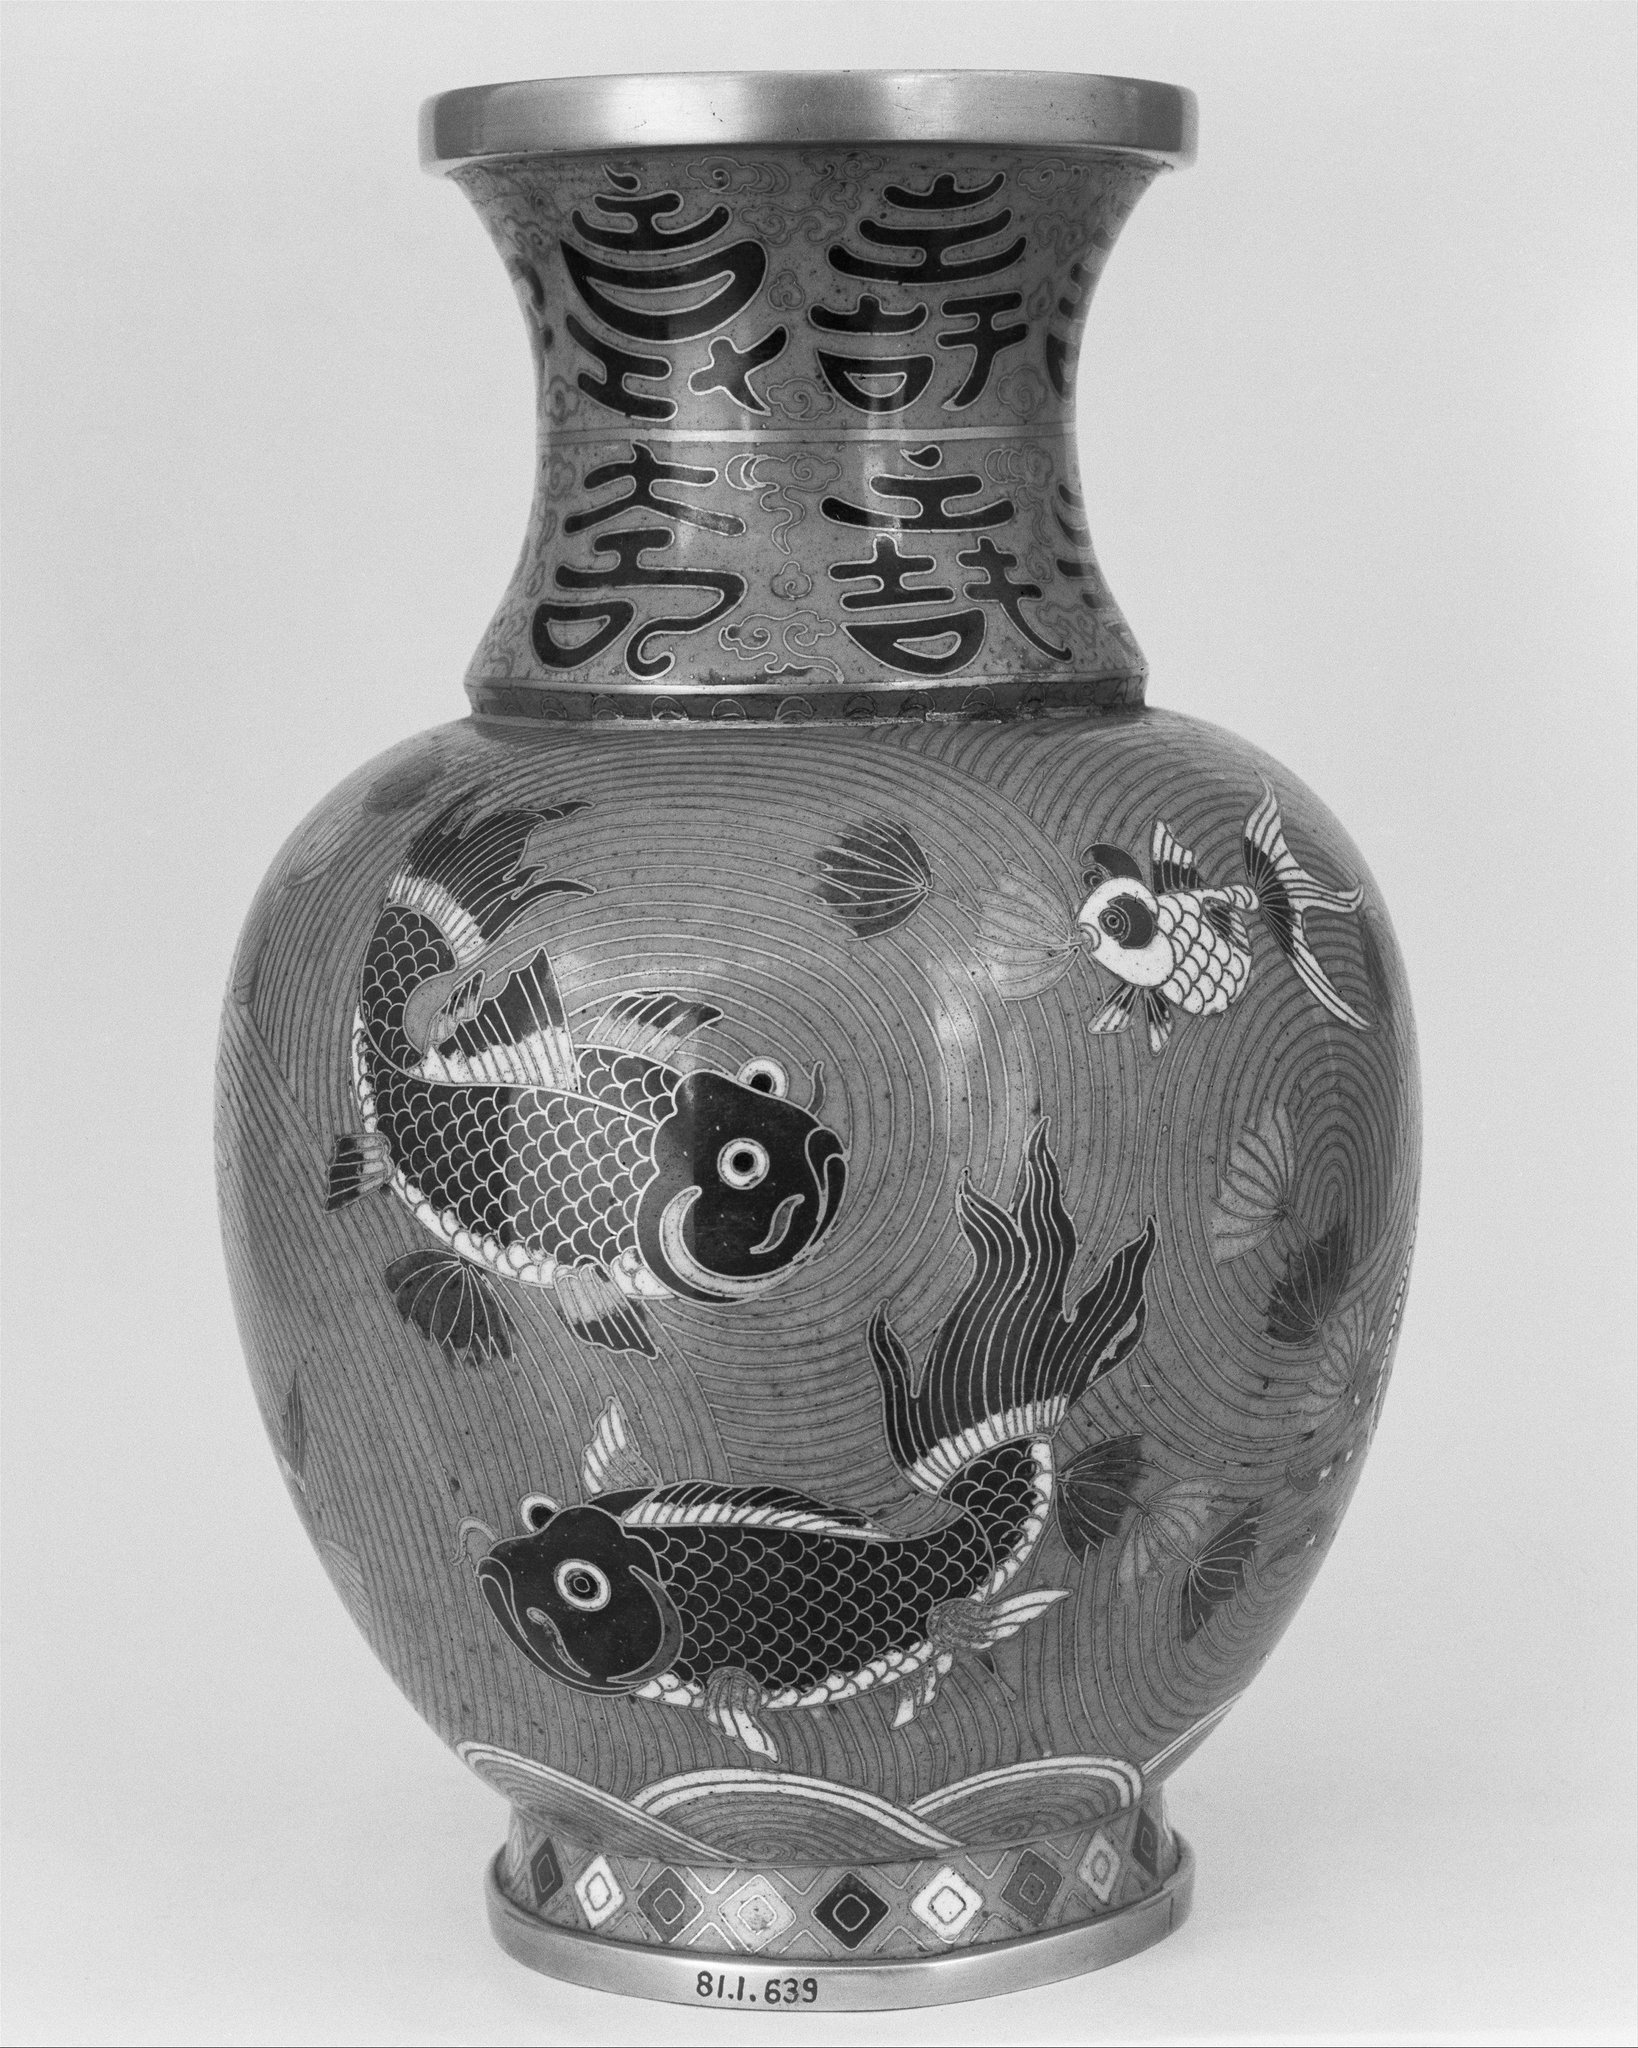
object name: vase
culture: japanese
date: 1801-1900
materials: enamel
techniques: enamel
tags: fish